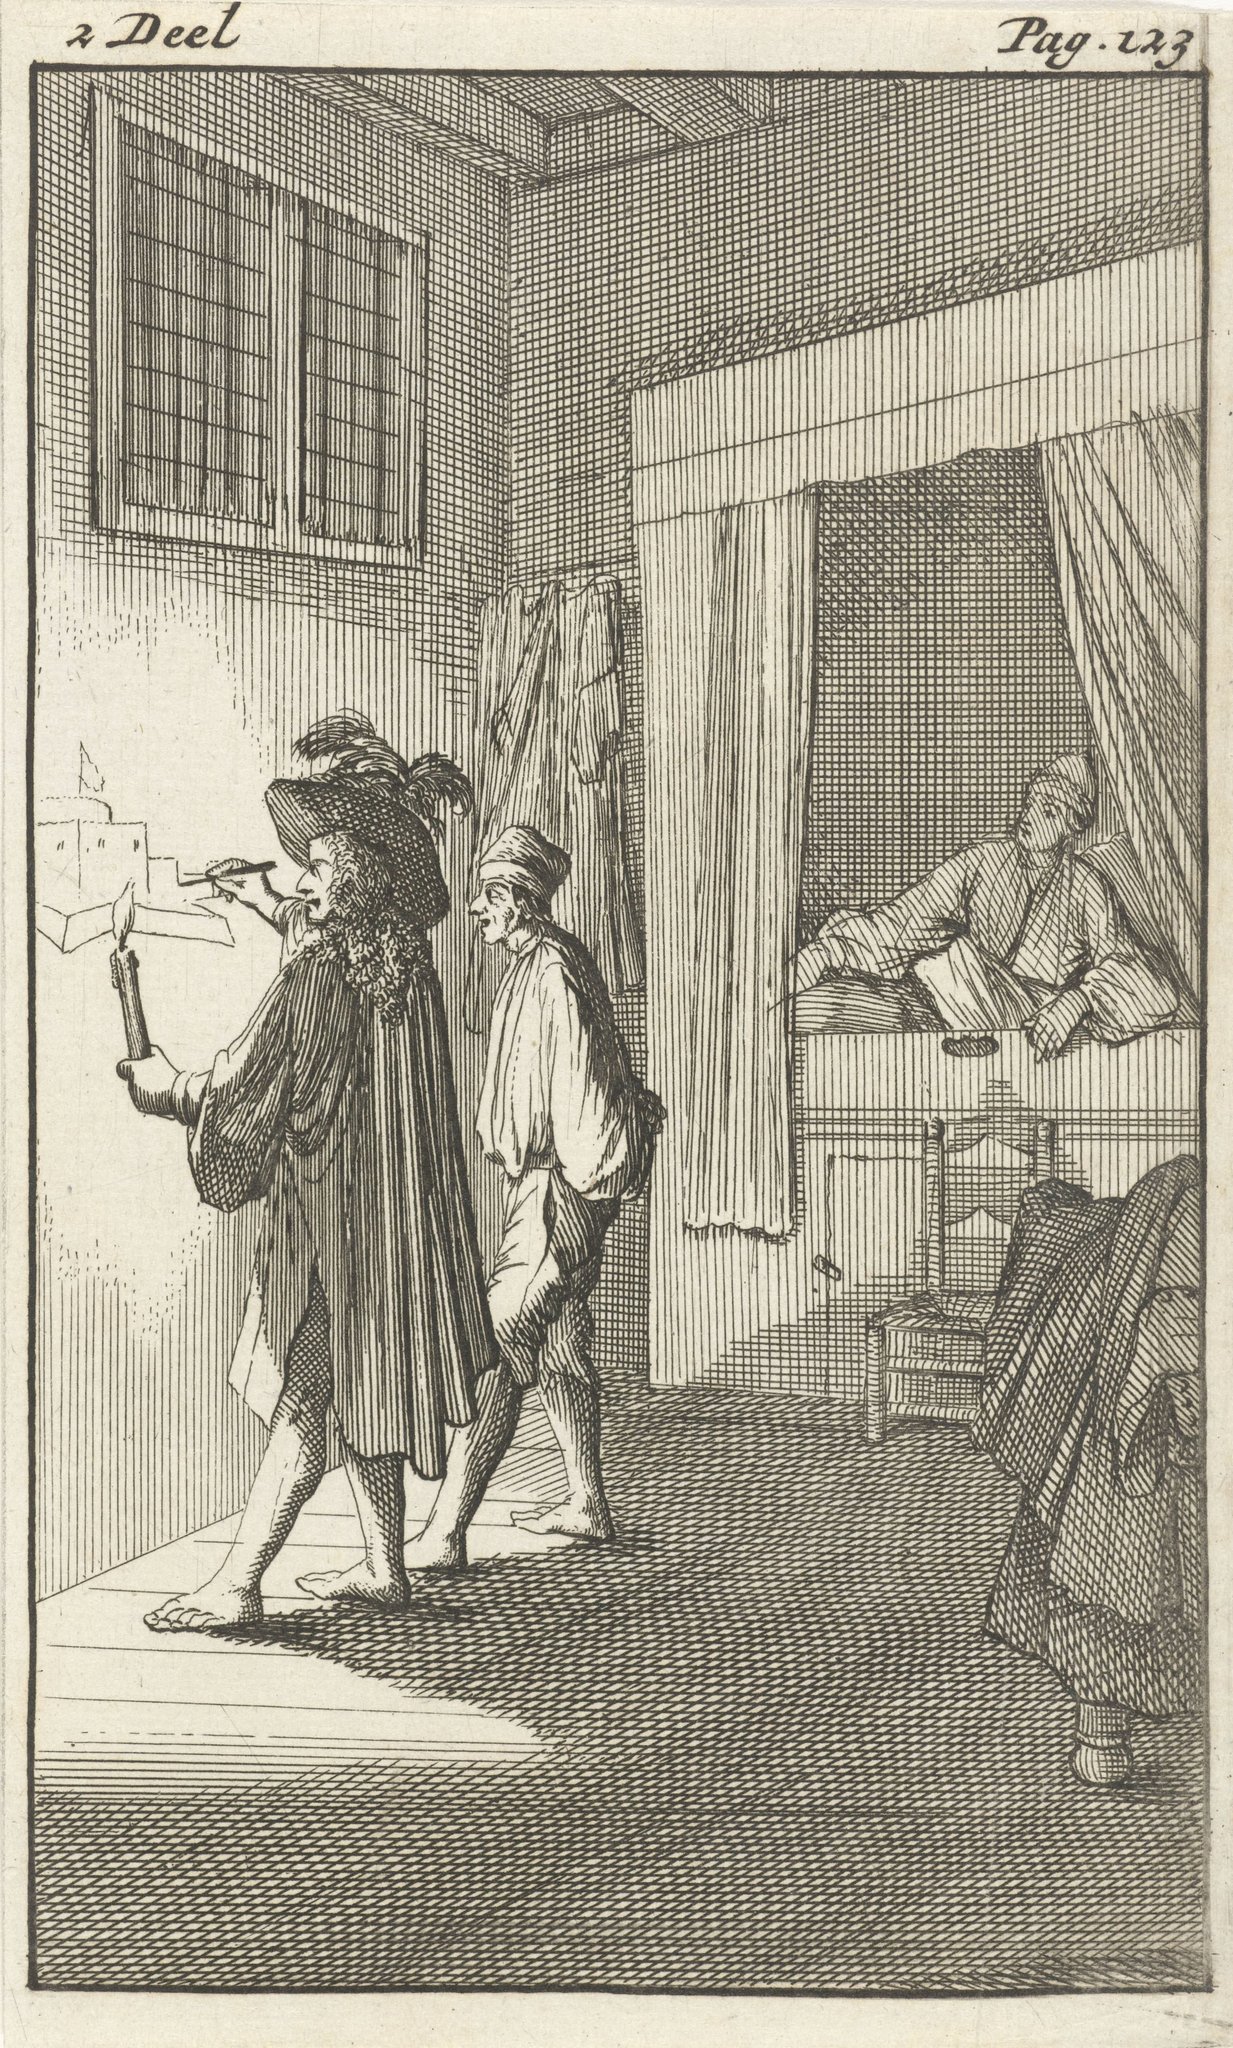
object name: print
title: Mirandor ziet vanuit zijn bedstee zijn medereiziger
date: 1695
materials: paper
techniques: etching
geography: amsterdam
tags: built-in bedstead (dutch: 'bedstee')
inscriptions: collector's mark: Lugt 2228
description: Illustratie uit: Heinsius, Nicolaas jr. Den vermakelyken avanturier, ofte De wispelturige, en niet min wonderlyke levens-loop van Mirandor, 2 delen. Amsterdam: Pieter van Amsterdam, 1695, dl. II.